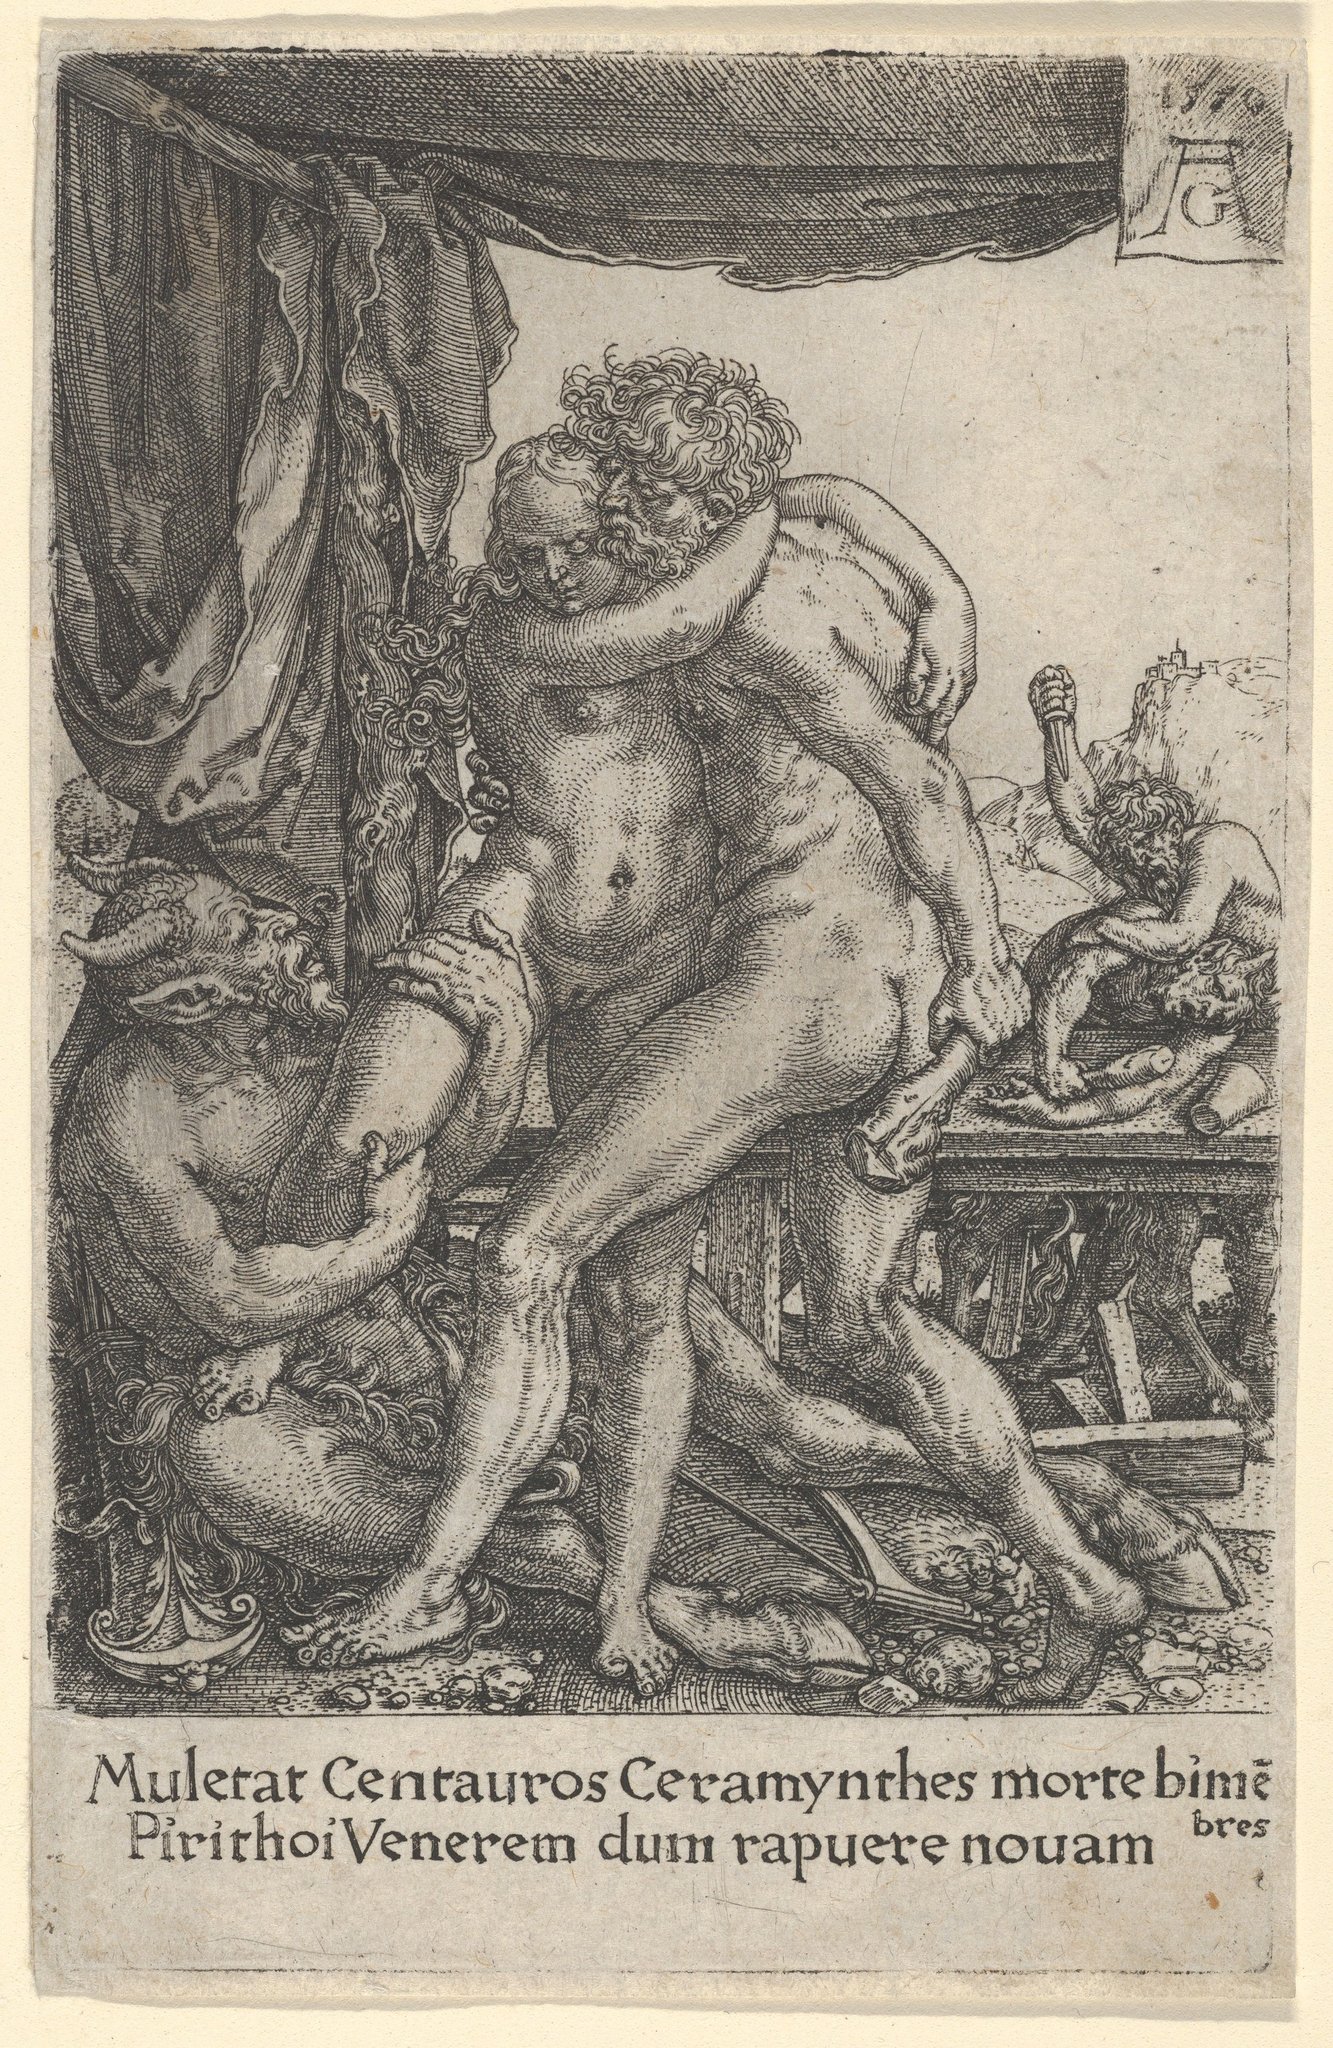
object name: print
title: Hercules Preventing the Centaurs from the Rape of Hippodameia, from The Labors of Hercules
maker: heinrich aldegrever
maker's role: artist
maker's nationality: german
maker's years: 1502-1561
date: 1550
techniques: engraving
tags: female nudes,hercules,centaurs